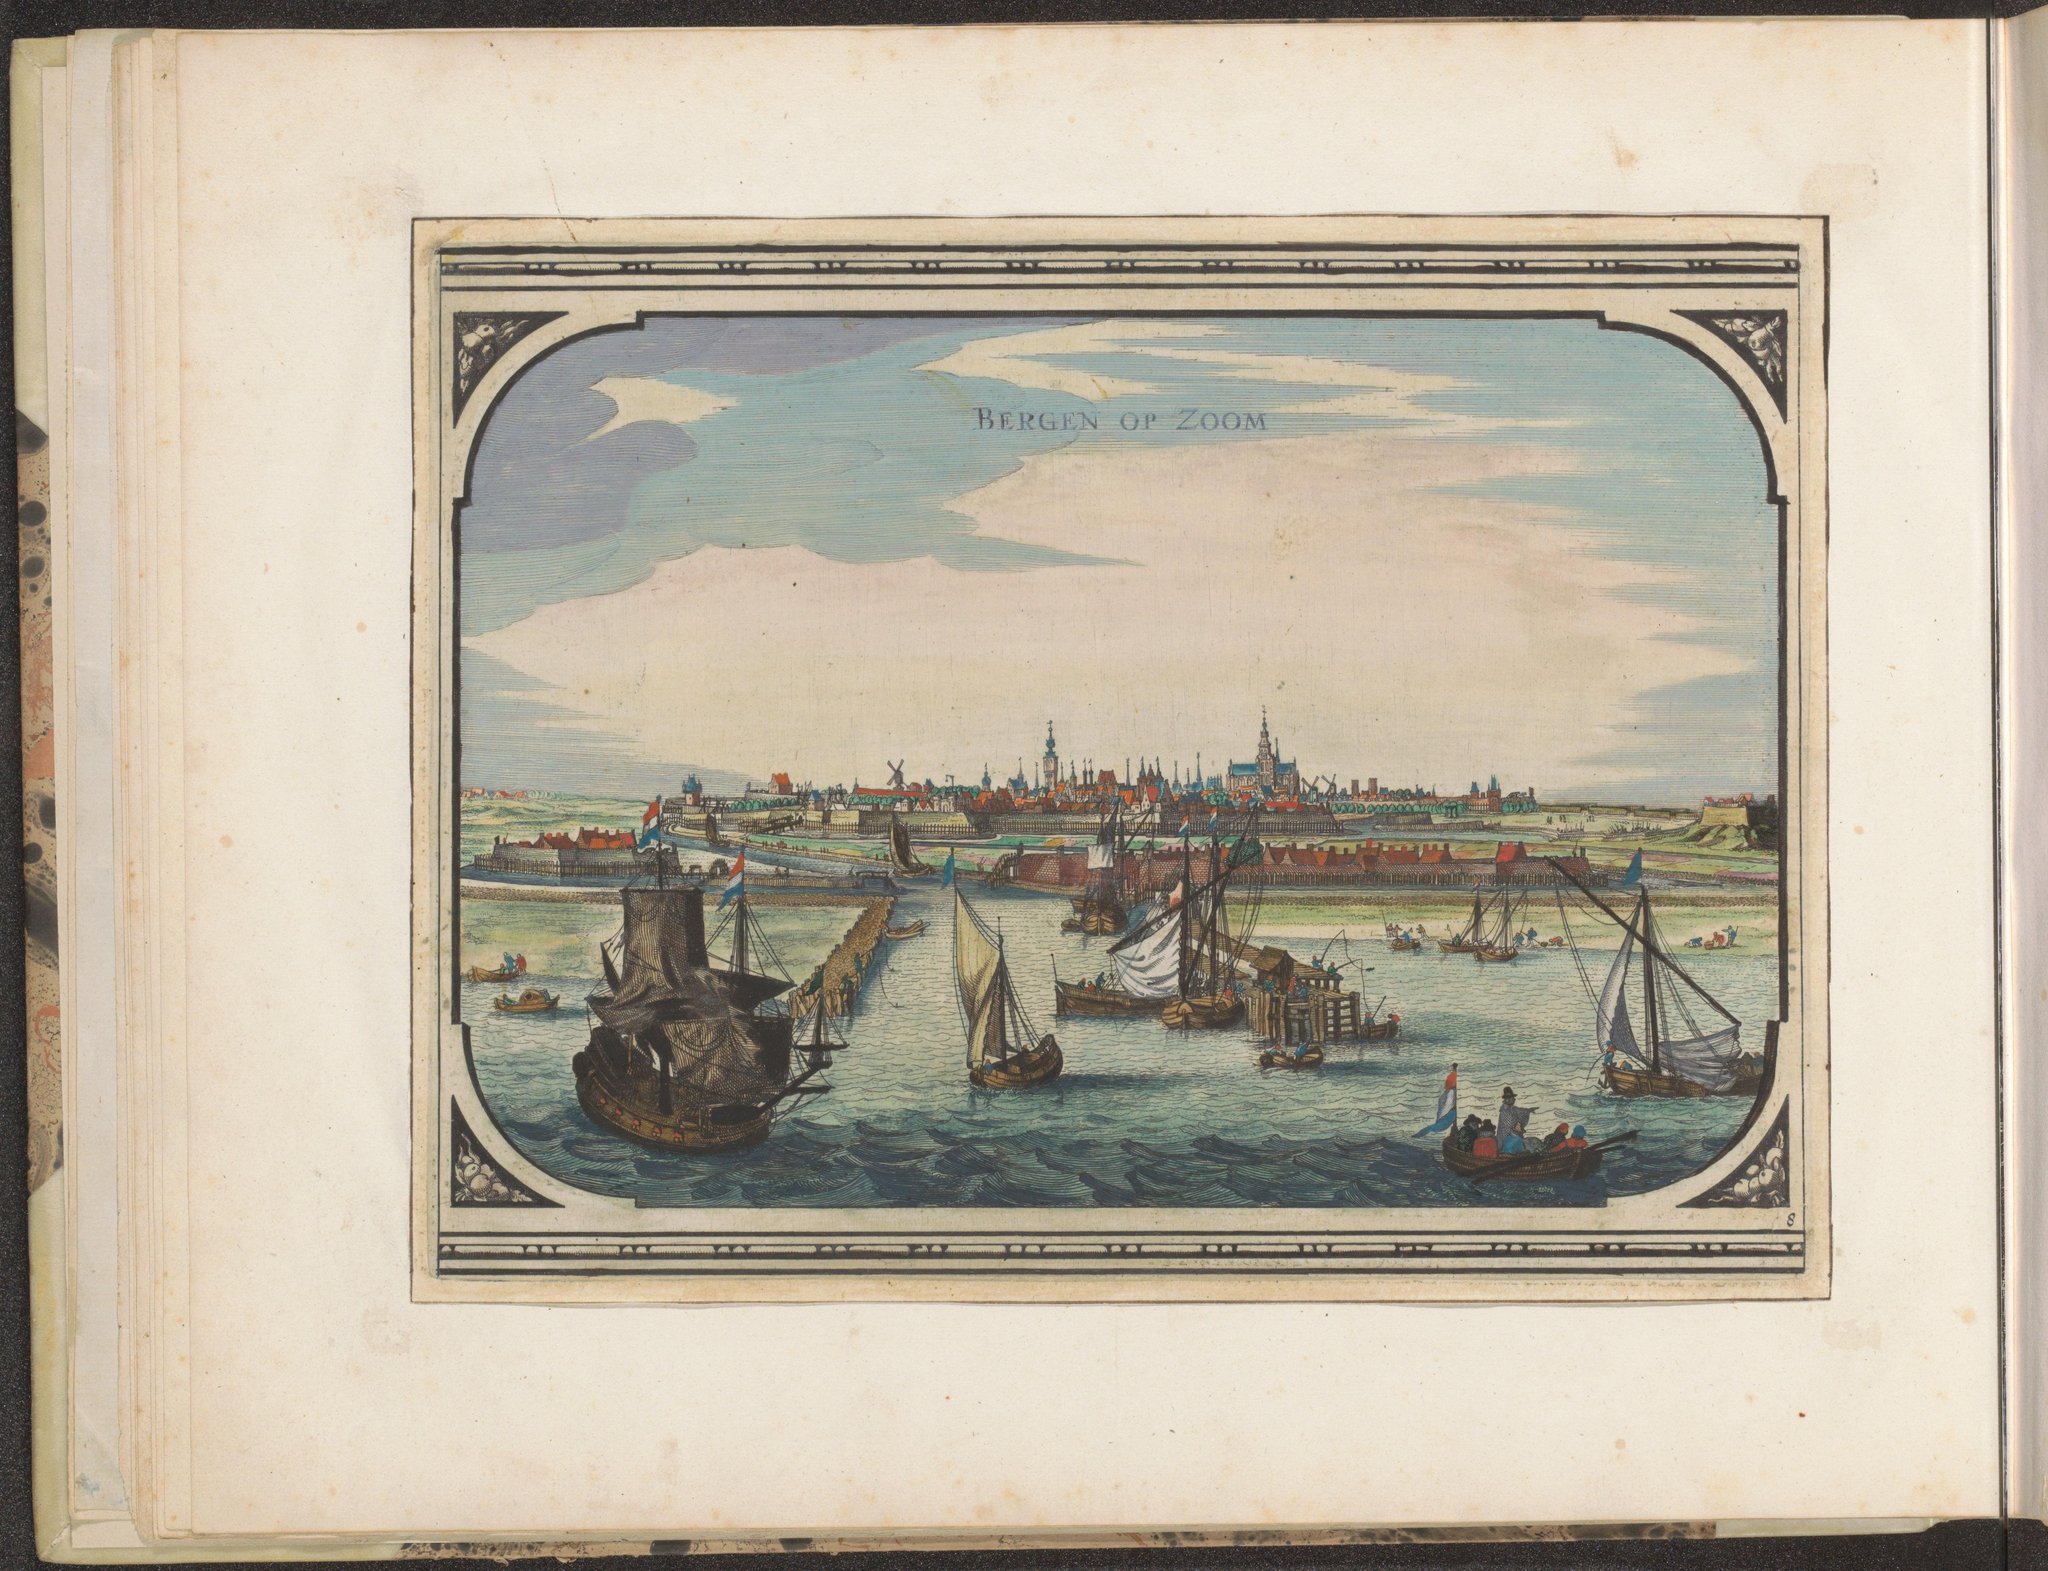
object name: album leaf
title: Gezicht op Bergen op Zoom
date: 1657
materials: paper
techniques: etching, hand coloring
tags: city-view, and landscape with man-made constructions, ships (in general), fisherman, bergen op zoom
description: Gezicht op de stad Bergen op Zoom, gezien vanaf de Schelde. Op de voorgrond schepen en bootjes. Op de aanlegsteigers vissers. De prent maakt deel uit van een album.